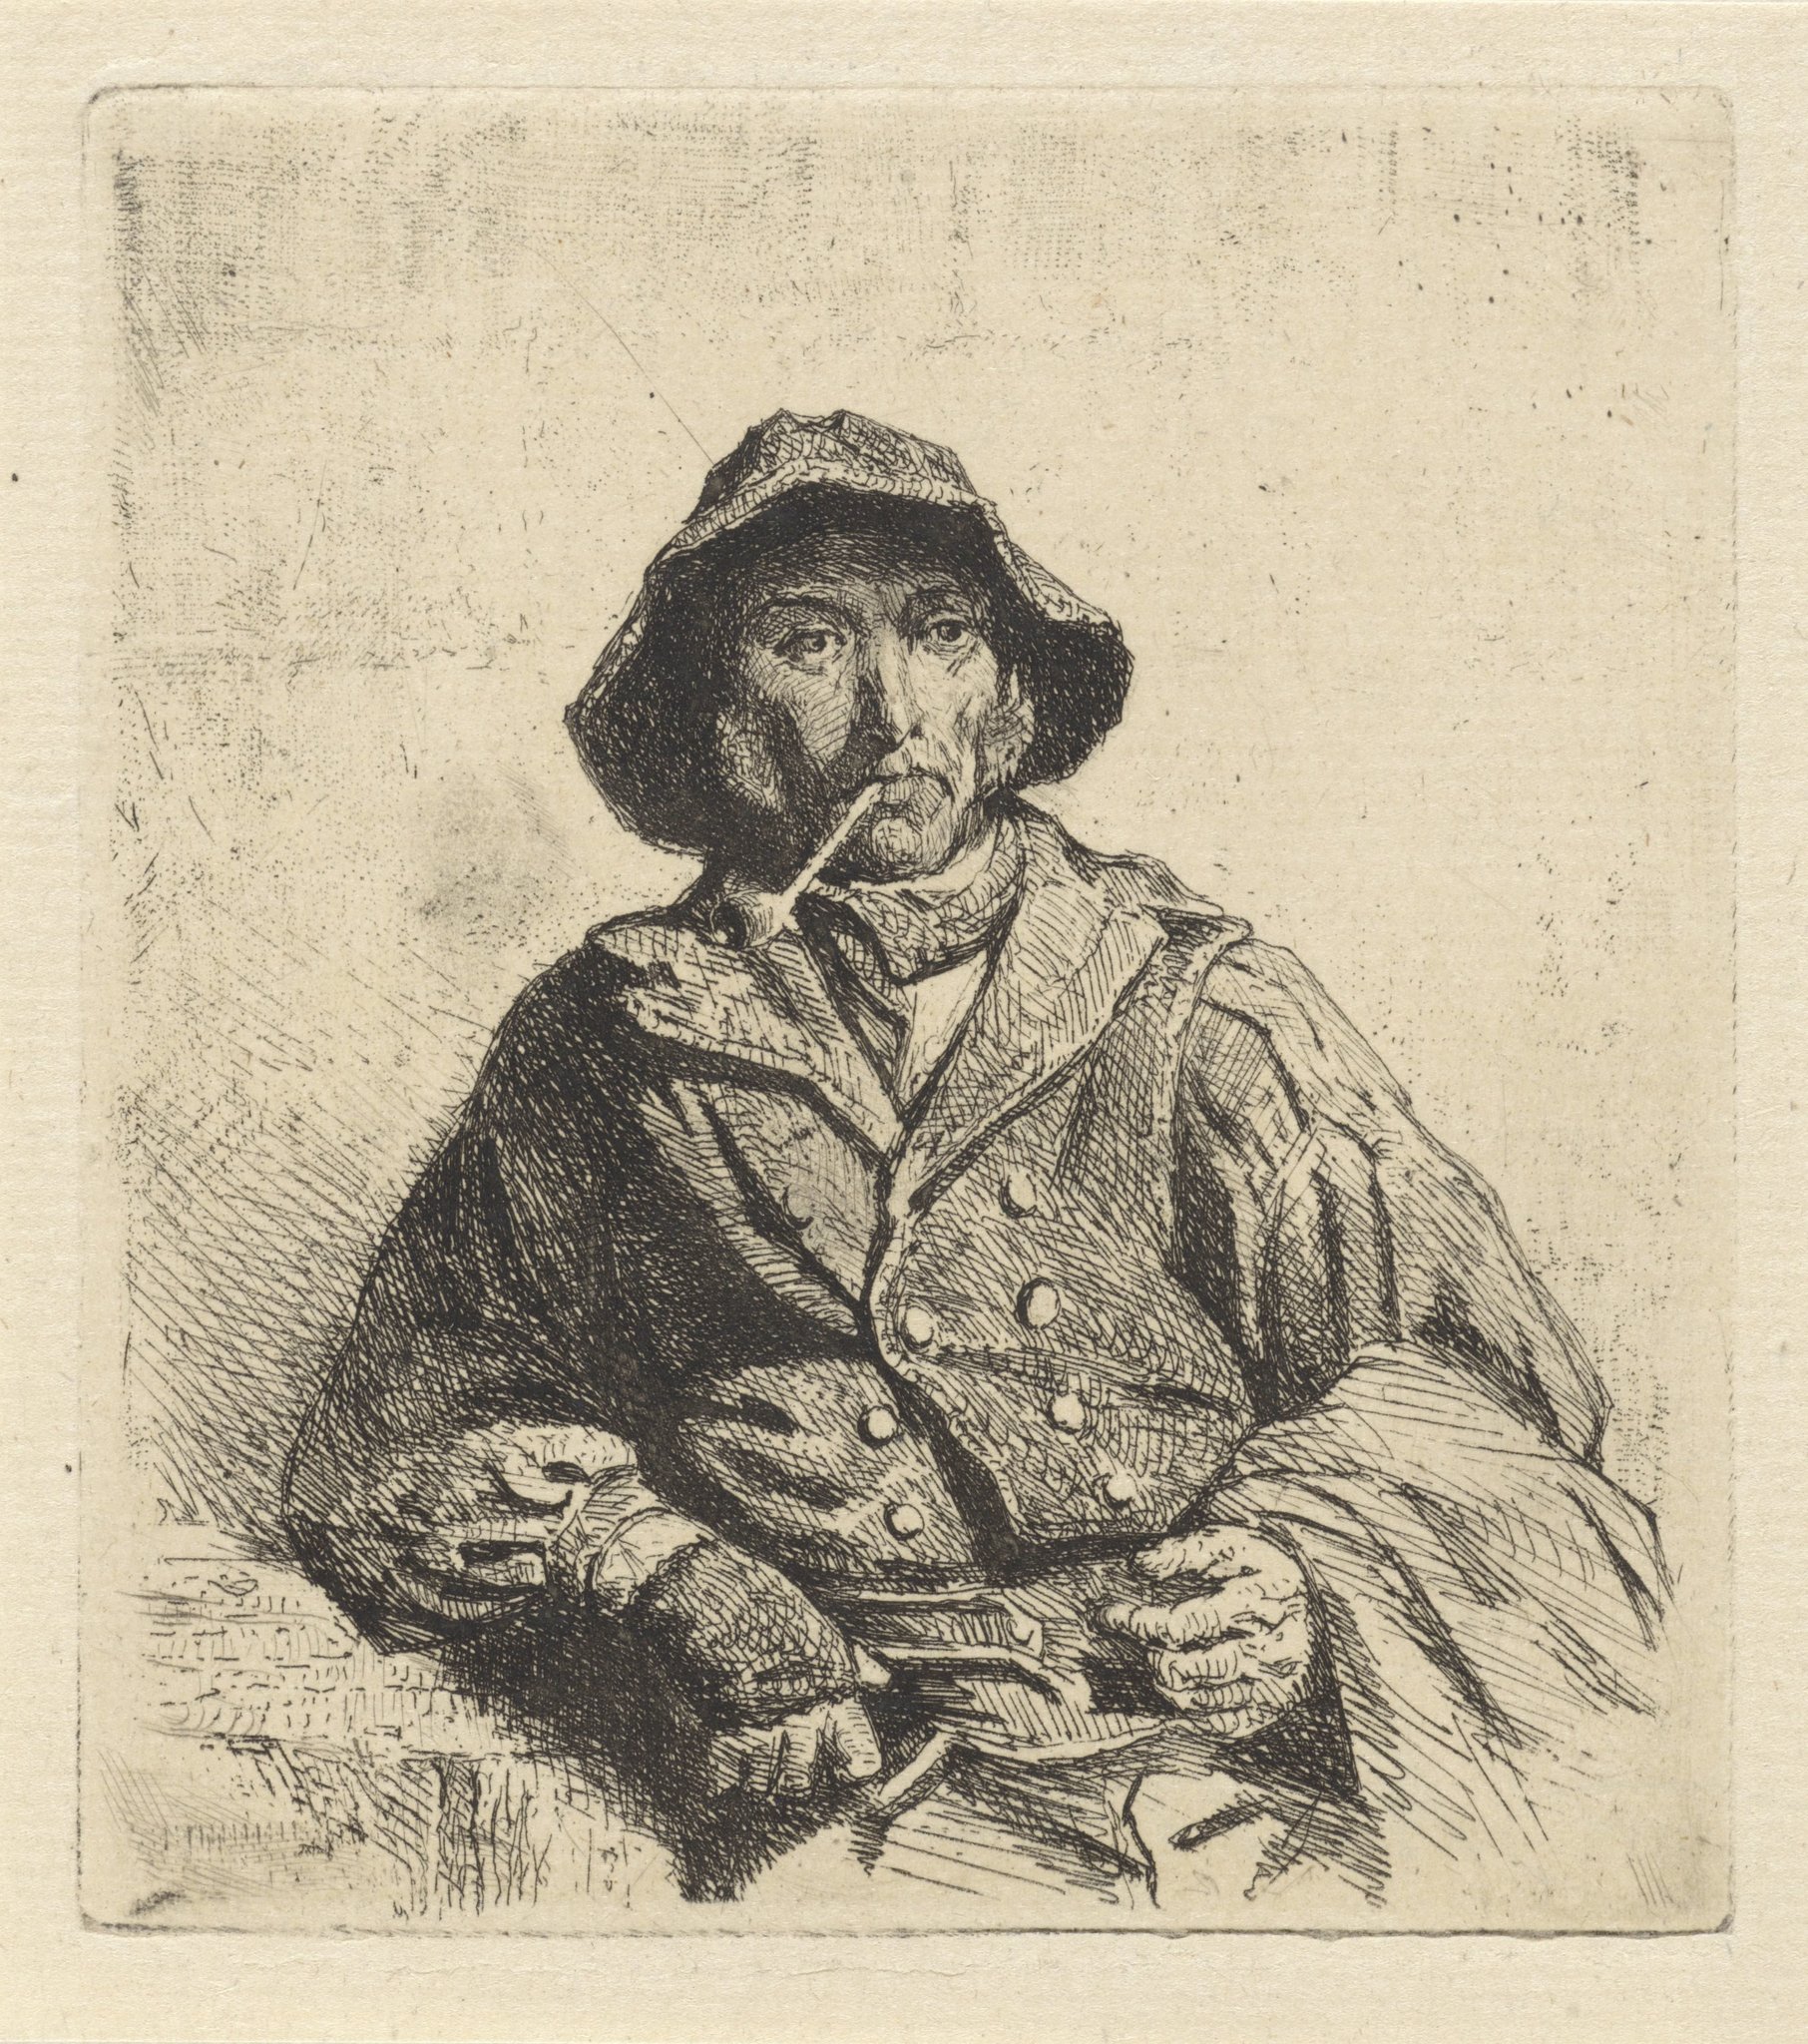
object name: print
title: Zeeman met een zuidwester en een pijp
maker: hendrik jacobus scholten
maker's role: draughtsman, painter, print maker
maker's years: 1824-1907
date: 1836-1886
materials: paper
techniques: etching, roulette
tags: pipe ~ tobacco, fisherman